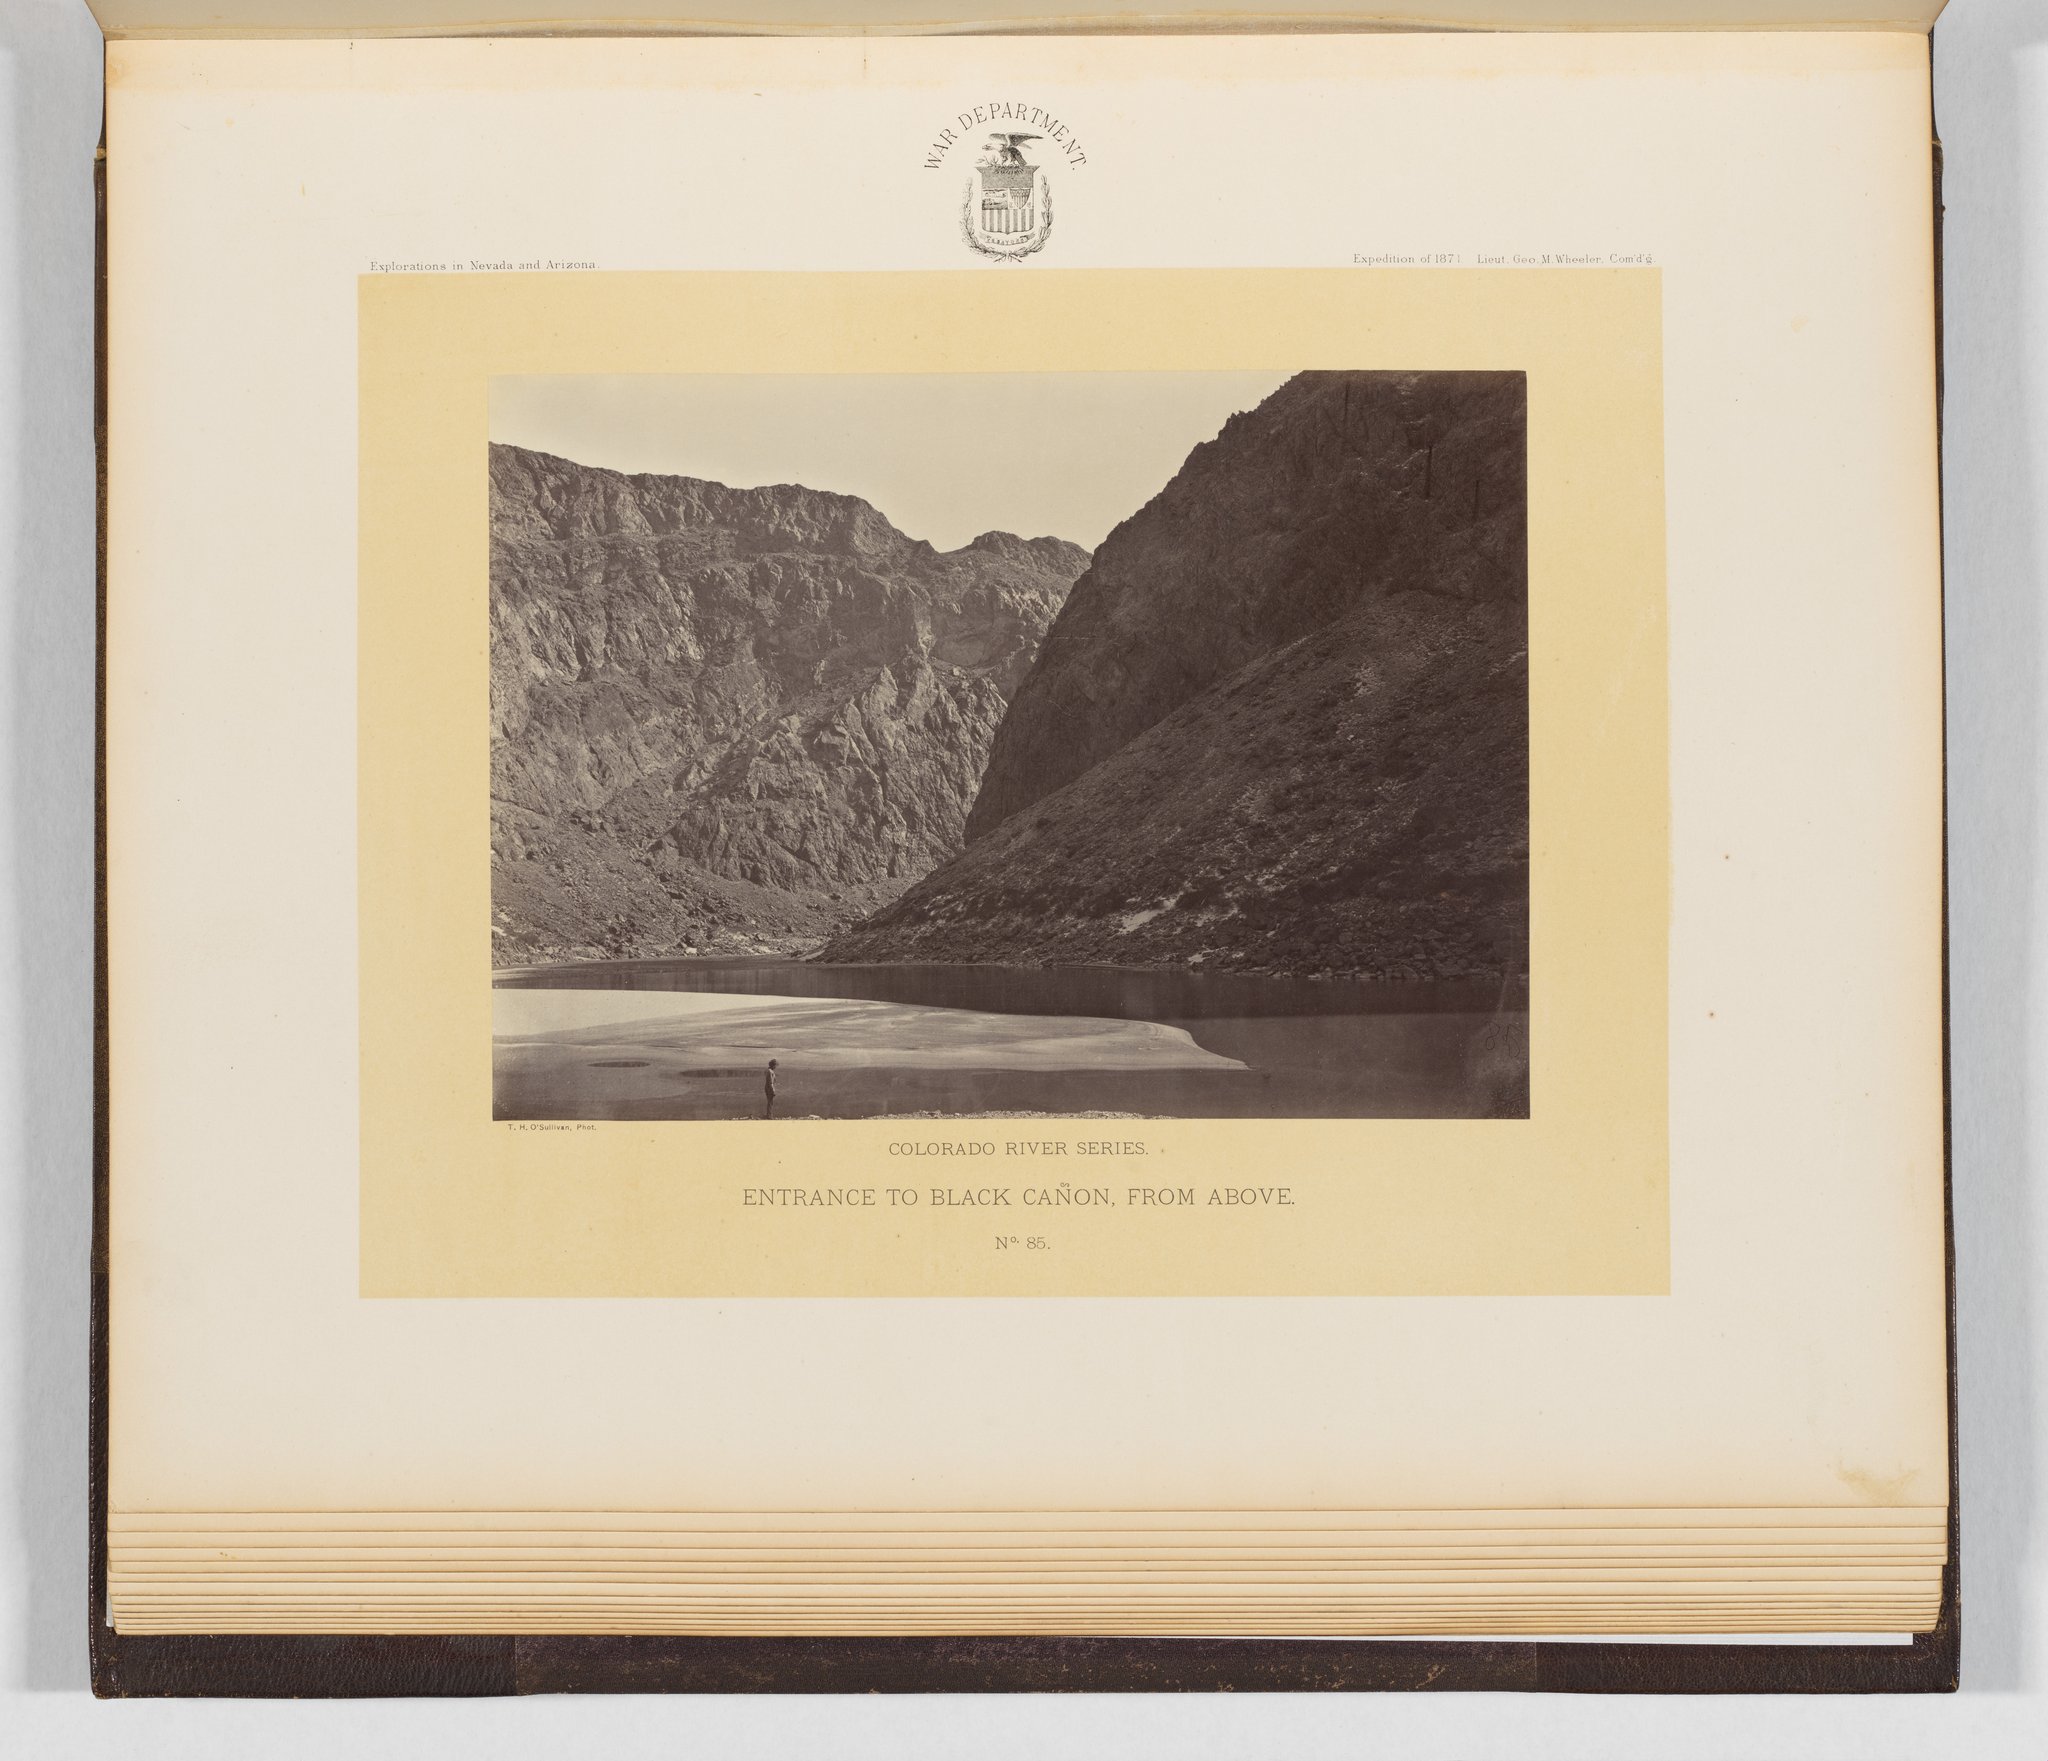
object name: photograph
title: Entrance to Black Cañon, From Above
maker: timothy h. o'sullivan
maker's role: artist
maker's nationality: american, born ireland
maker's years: 1840-1882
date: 1871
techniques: albumen silver print, glass negative